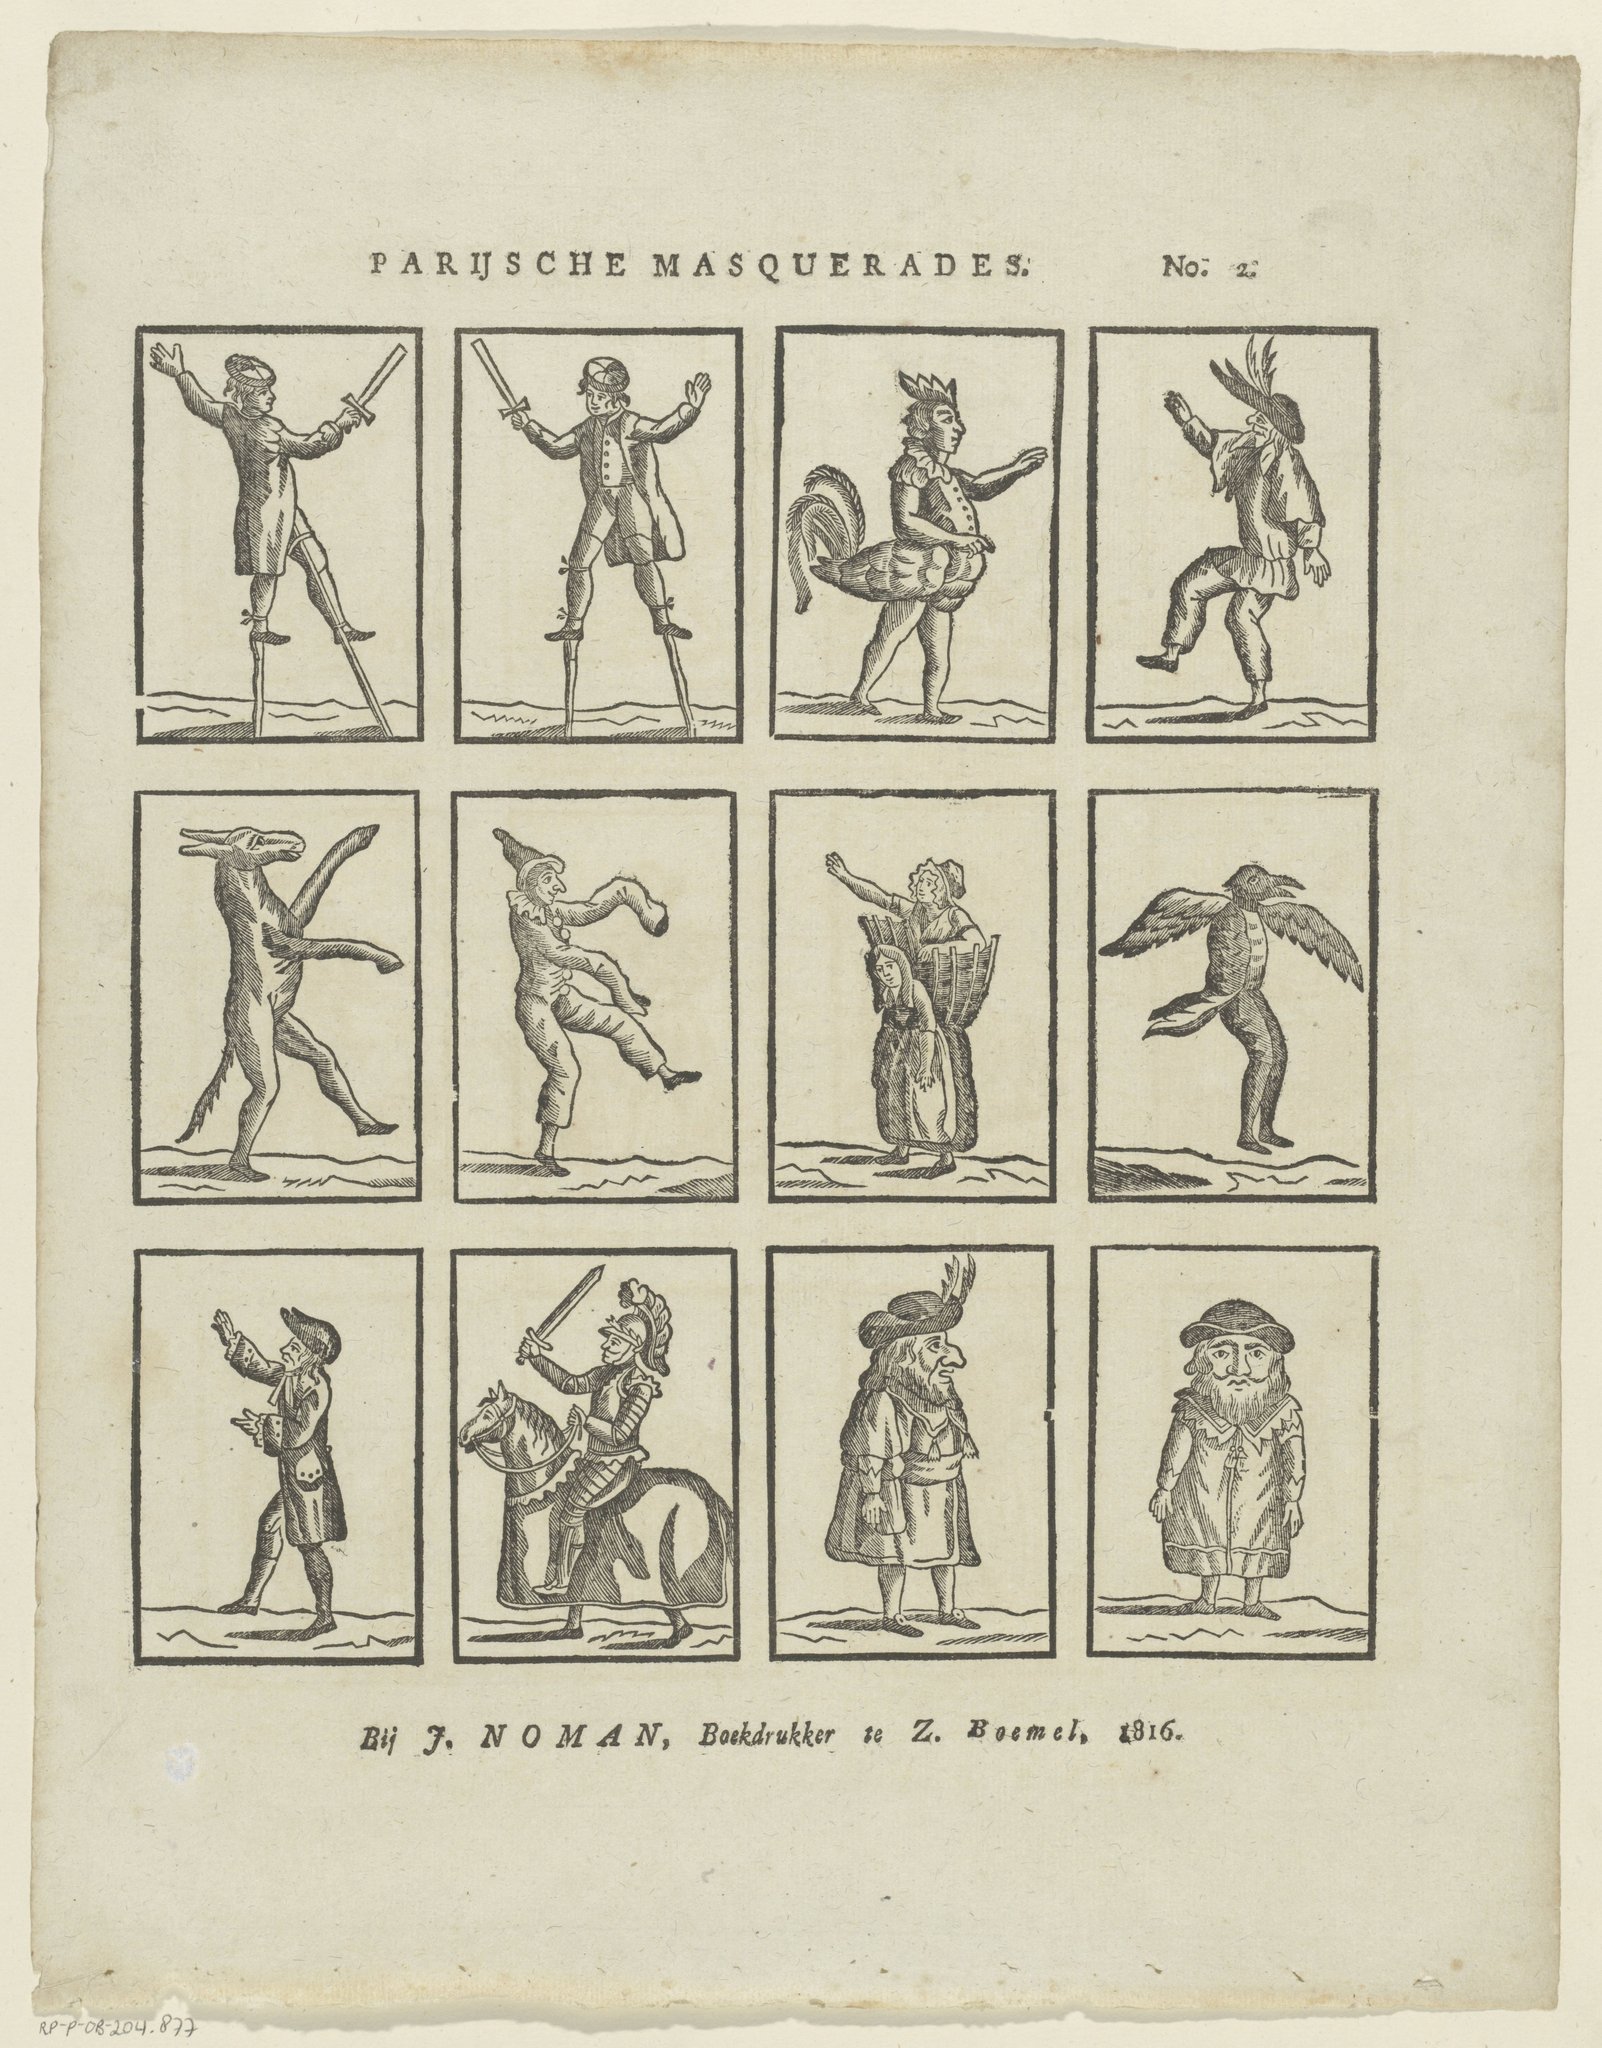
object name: print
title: Parijsche masquerades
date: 1806-1830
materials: paper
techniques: letterpress printing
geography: netherlands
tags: masquerade, masked ball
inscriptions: collector's mark: Lugt 2760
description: Blad met 12 voorstellingen van verklede personen. Genummerd rechtsboven: No. 2.